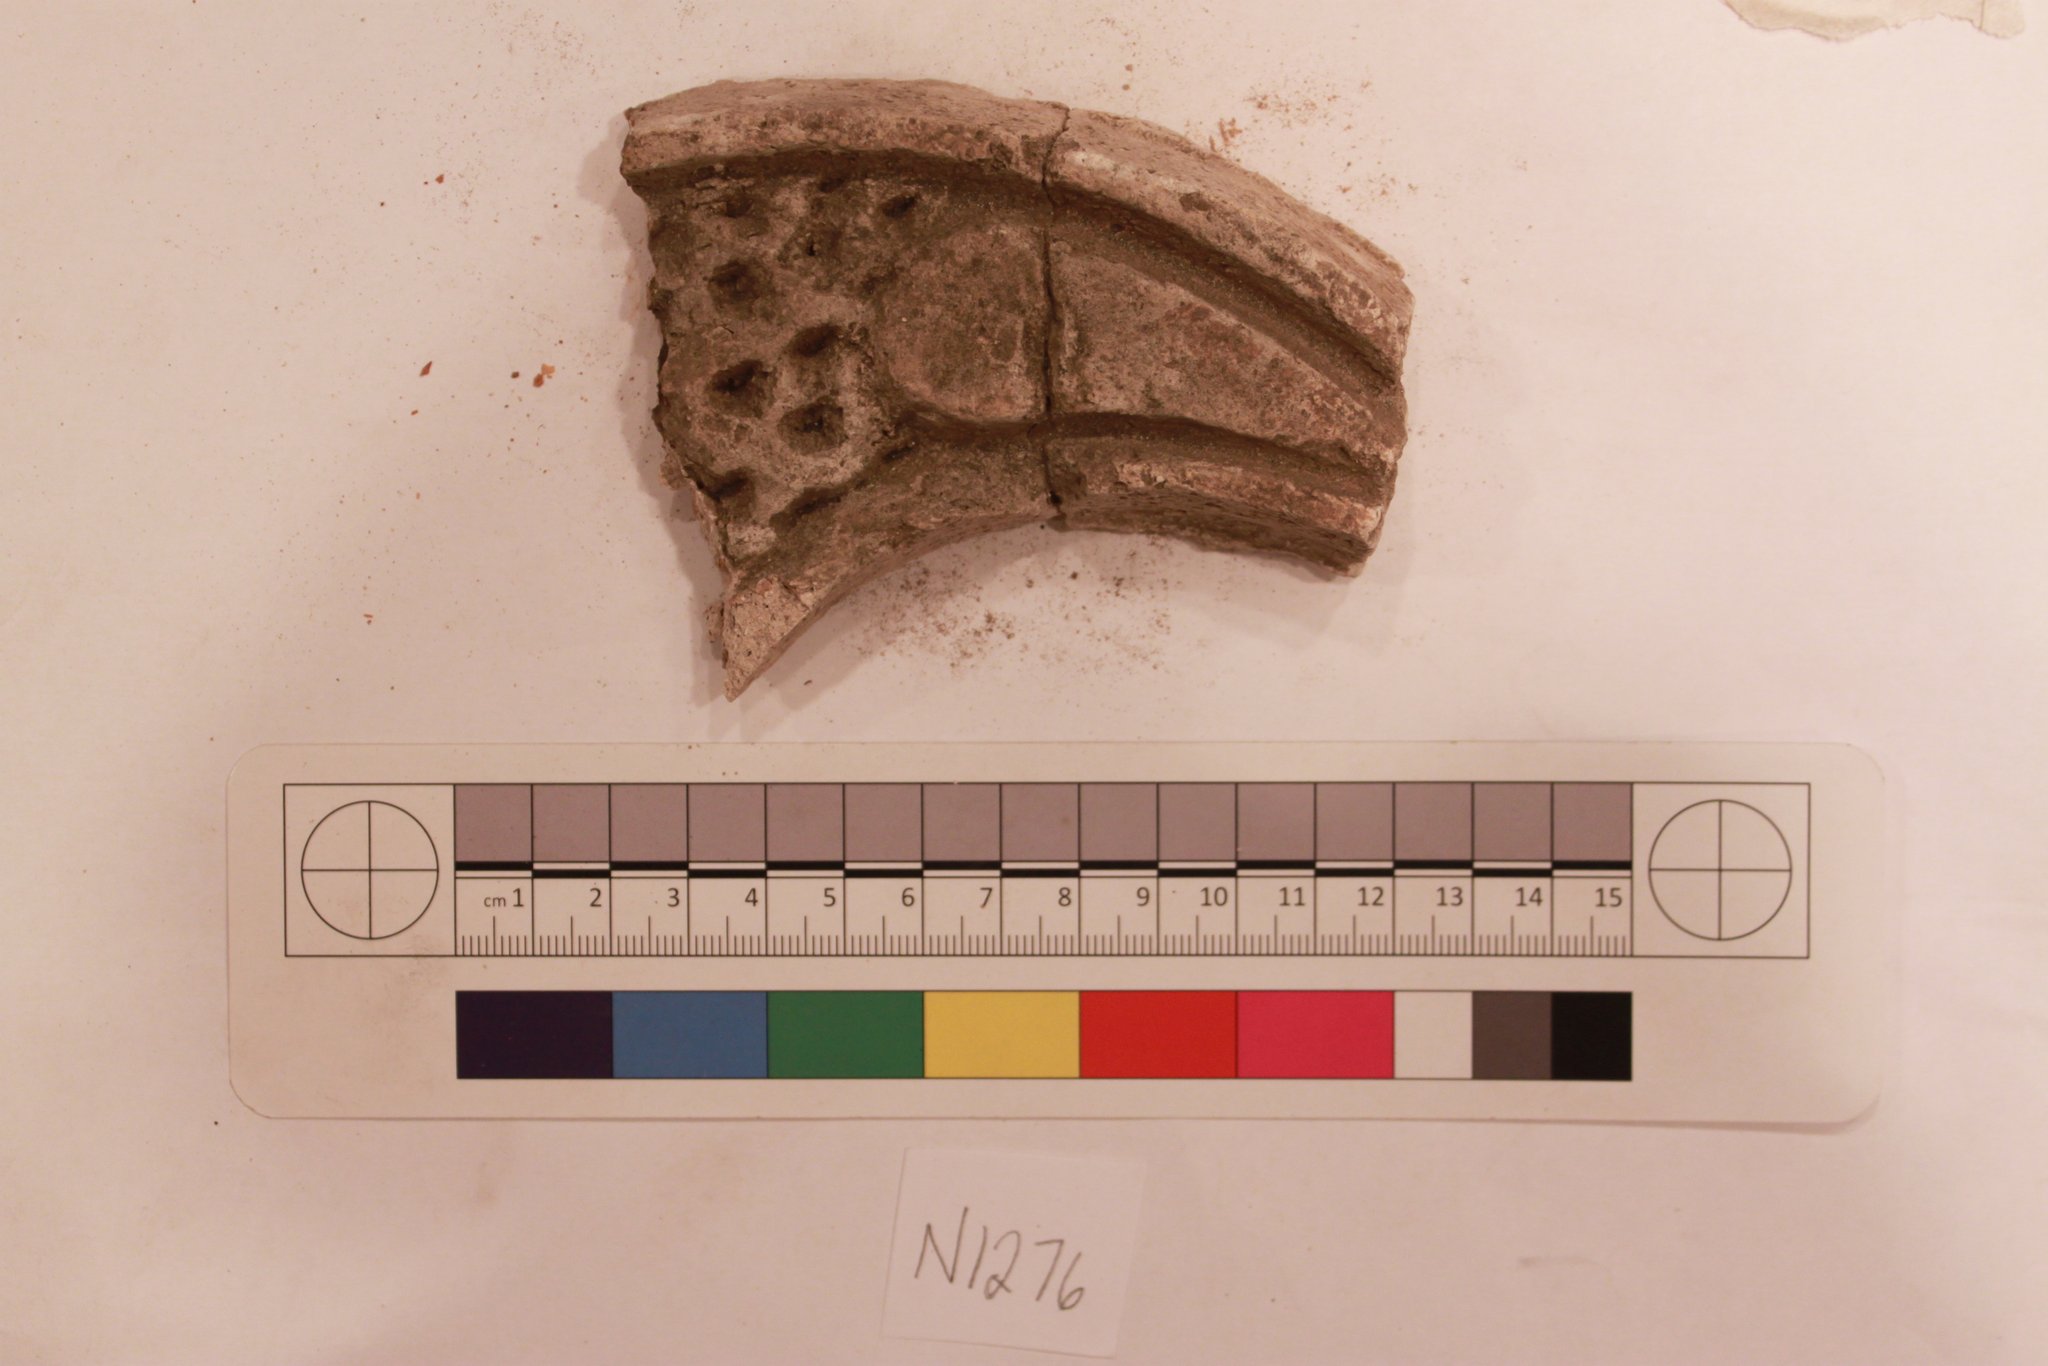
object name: fragment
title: Stucco Fragment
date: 701-1200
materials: plaster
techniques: carving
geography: iran